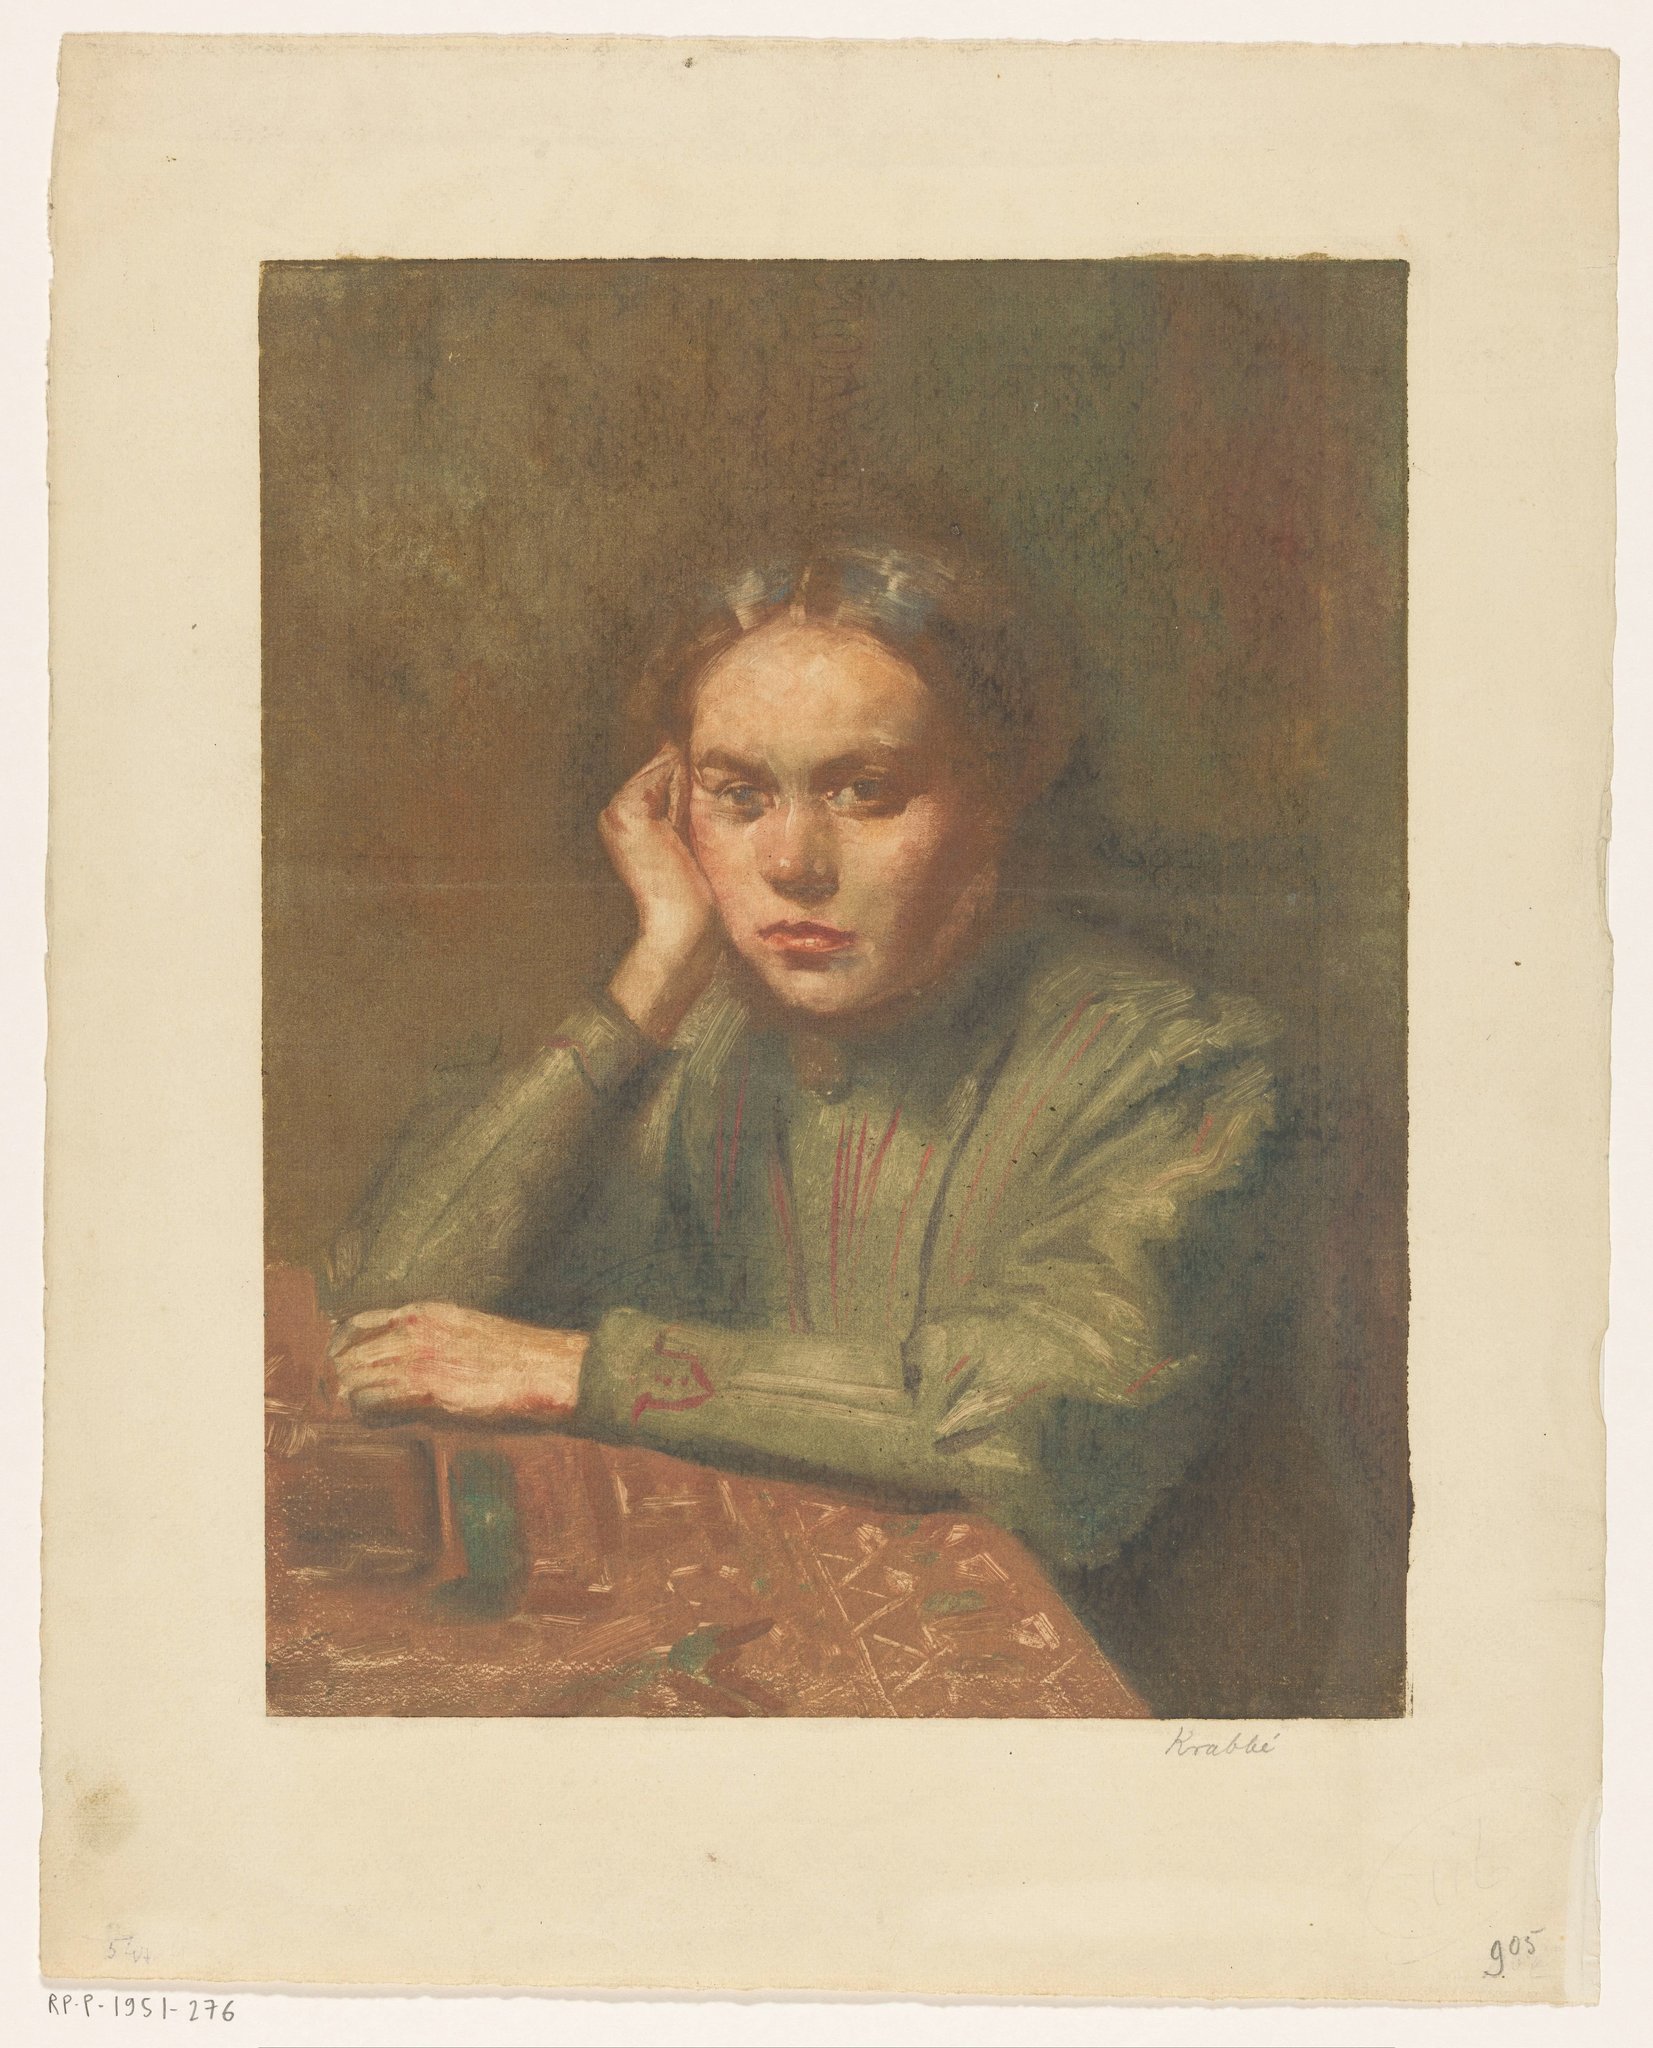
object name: print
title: Portret van een onbekende vrouw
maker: heinrich m. krabbé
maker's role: draughtsman, print maker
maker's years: 1868-1931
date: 1878-1931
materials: paper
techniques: color mezzotint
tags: anonymous historical person portrayed, head held in the hand(s), with elbows leaning on an elevation or on the knees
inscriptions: collector's mark: Lugt 2228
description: Portret van een vrouw die aan een tafel zit. Ze ondersteunt haar hoofd met haar hand. Haar elleboog rust op tafel.